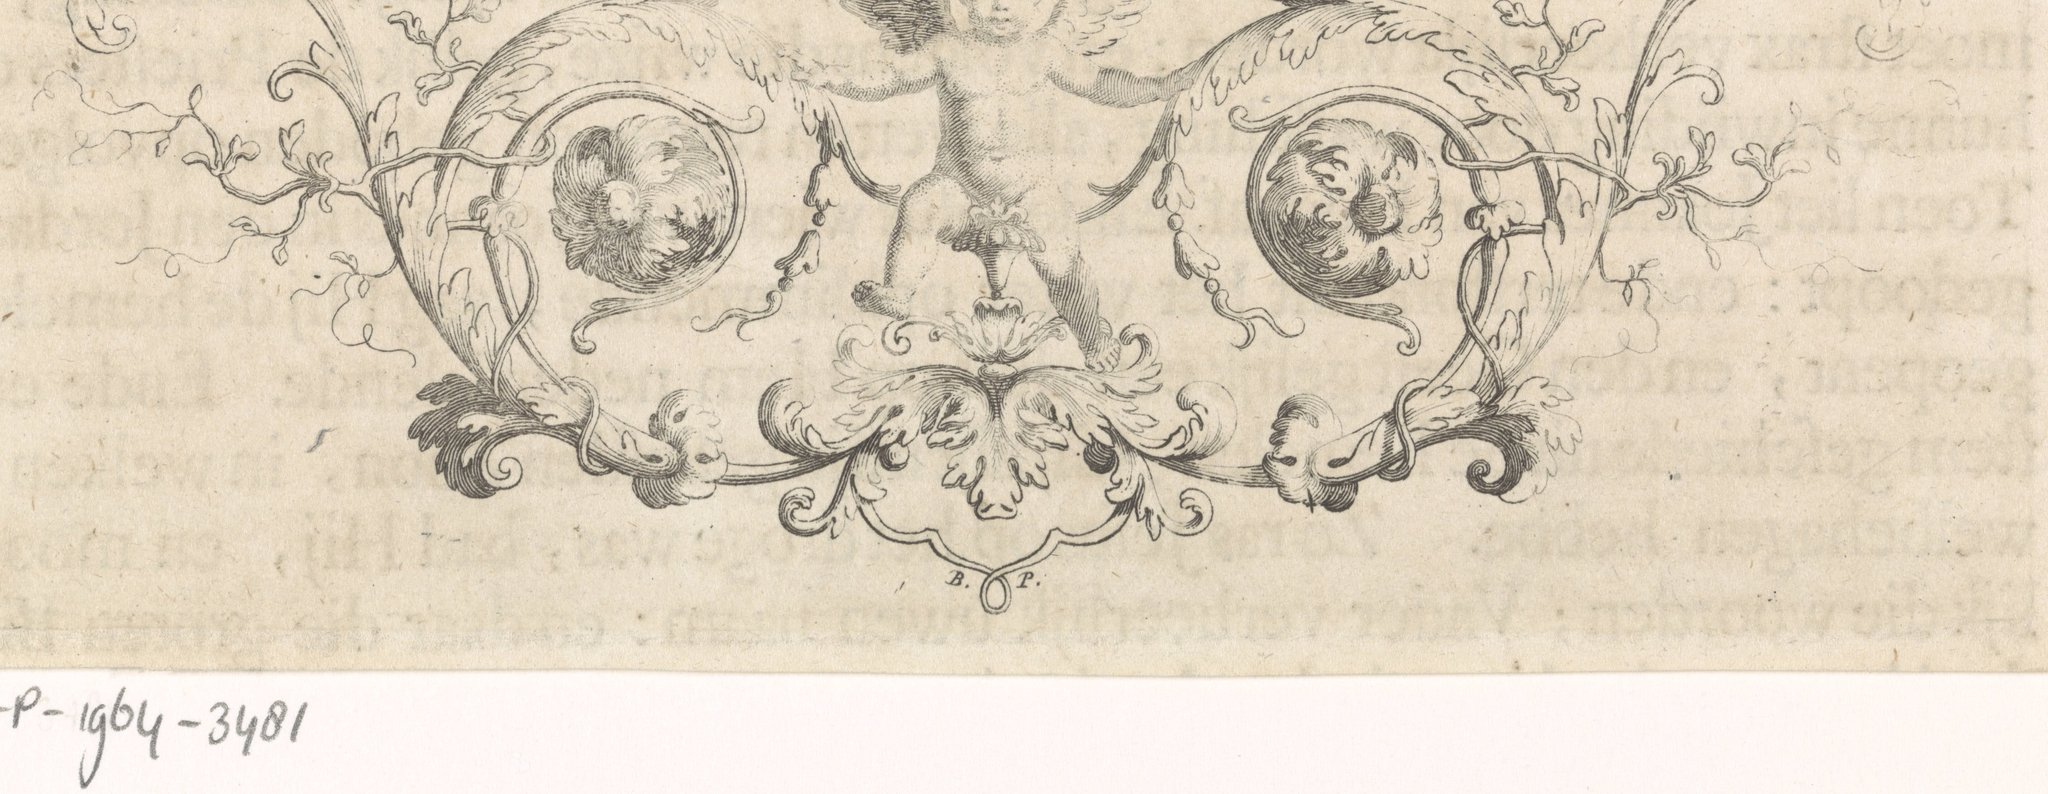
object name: print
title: Ornament met bladranken en putto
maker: bernard picart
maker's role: draughtsman, print maker, publisher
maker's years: 1673-1733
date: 1683-1733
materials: paper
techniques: engraving, etching, letterpress printing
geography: amsterdam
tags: foliage, tendrils, branches ~ ornament, cupids: 'amores', 'amoretti', 'putti'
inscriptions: collector's mark: Lugt 2228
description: Prent oorspronkelijk bedoeld voor: Figures de la Bible. Amsterdam, Bernard Picart, 1720. Prent ook gebruikt in: Taferelen der voornaamste geschiedenissen van het Oude en Nieuwe Testament (...) door de vermaarde kunstenaars Hoet, Houbraken, en Picart getekent (...) en met beschrijvingen uitgebreid. Den Haag: Pieter de Hondt, 1728. Prent kan mogelijk ook zijn gebruikt in andere bijbels.